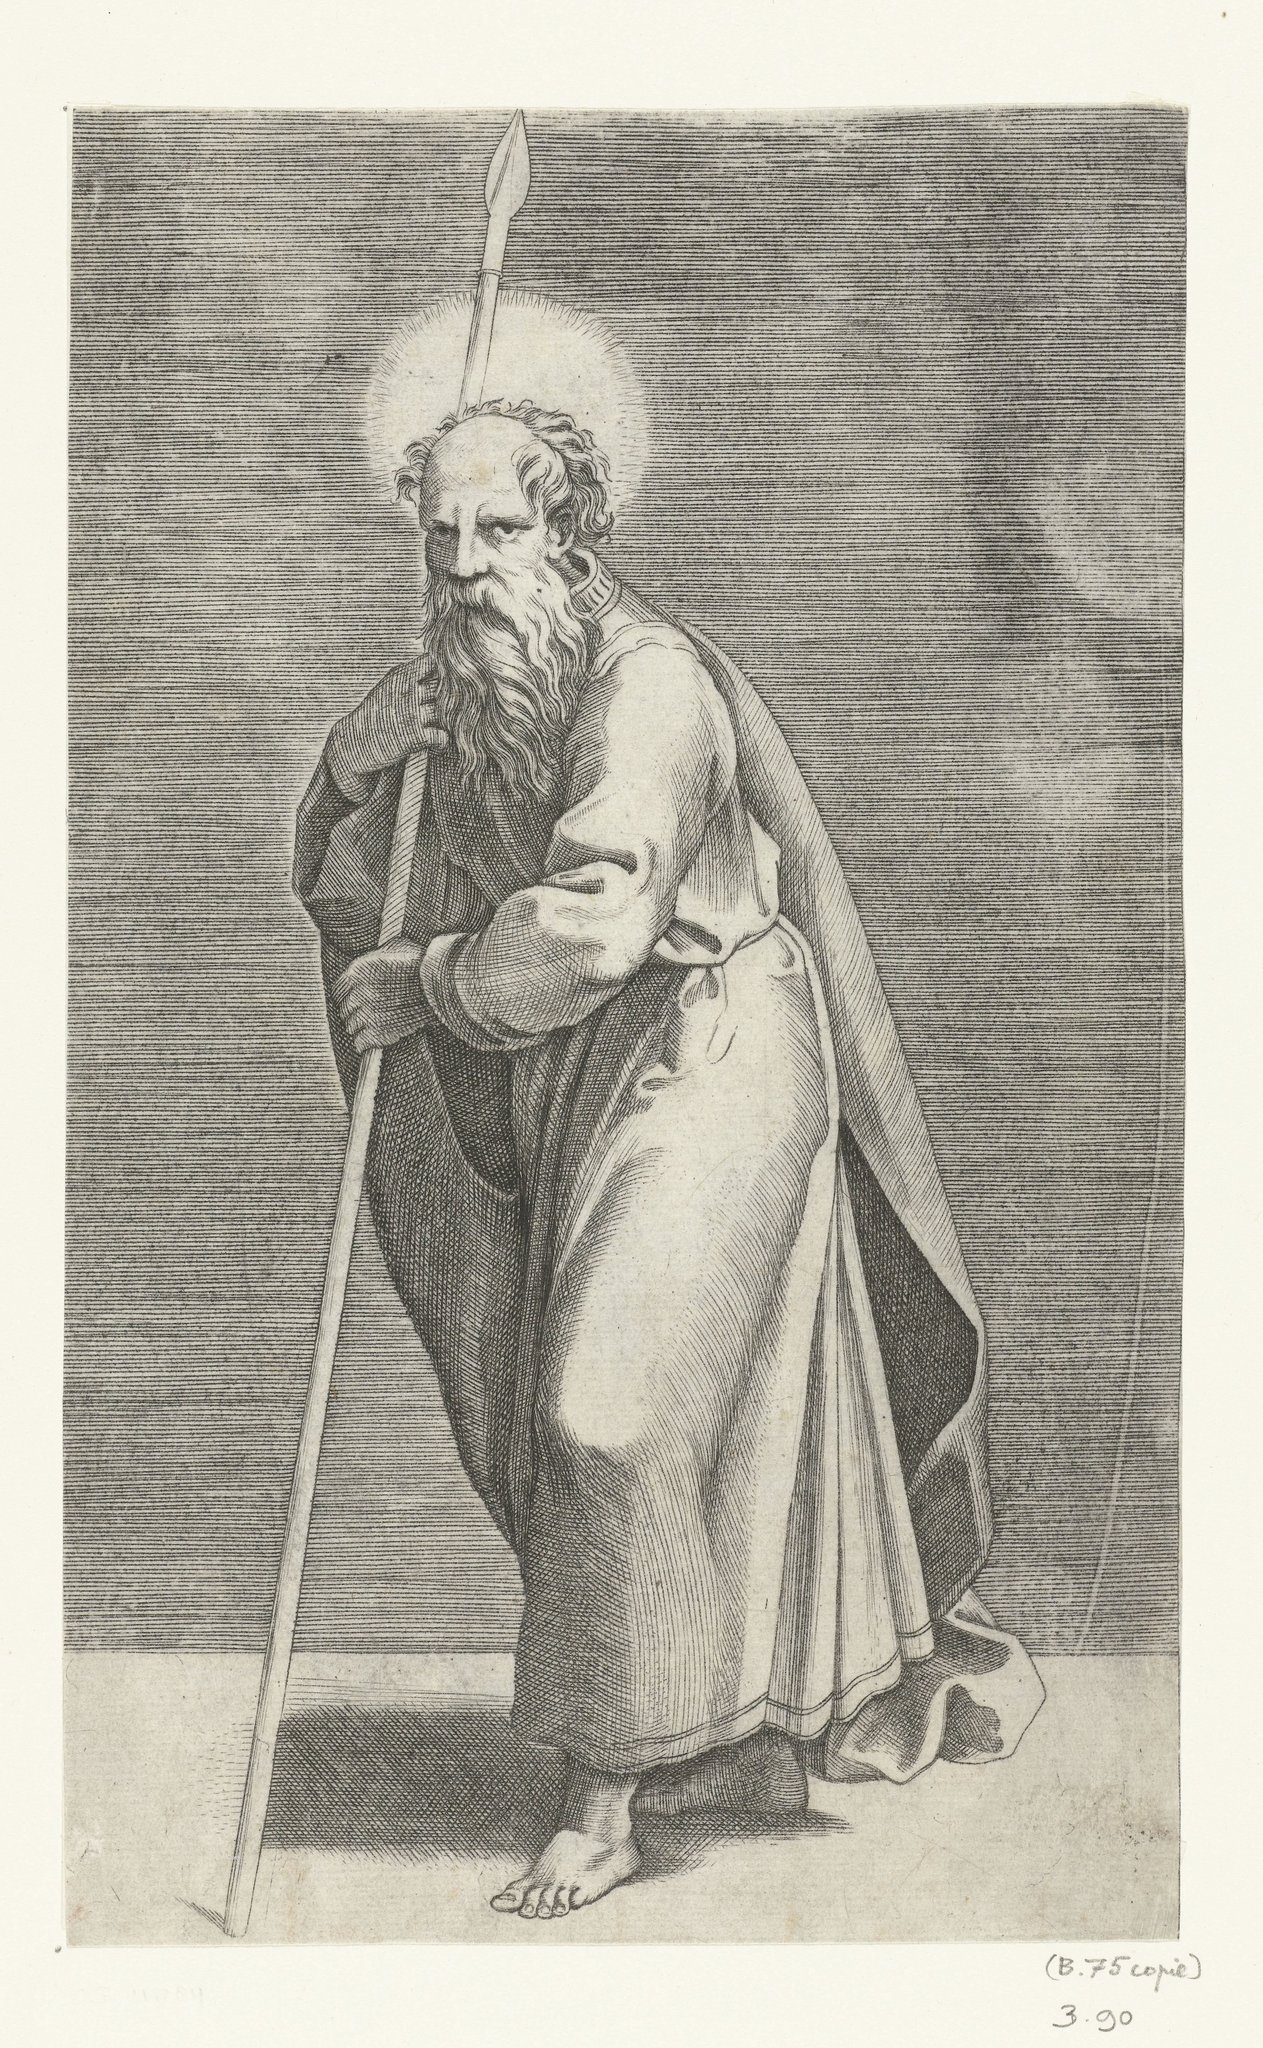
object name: print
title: Christus en de Apostelen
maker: marco dente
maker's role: print maker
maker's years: 1486-1527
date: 1517-1527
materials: paper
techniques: engraving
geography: italy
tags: the apostle and martyr matthias; possible attributes: axe, book, cross, halberd, scroll, sword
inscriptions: collector's mark: Lugt 240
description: Kopie naar pernt van Marcantonio Raimondi. Raimondi op zijn beurt baseerde zich op een ontwerp van Raphael. Op deze druk ontbreekt linksonder het monogram van Marco Dente dat bij Bartsch beschreven wordt.